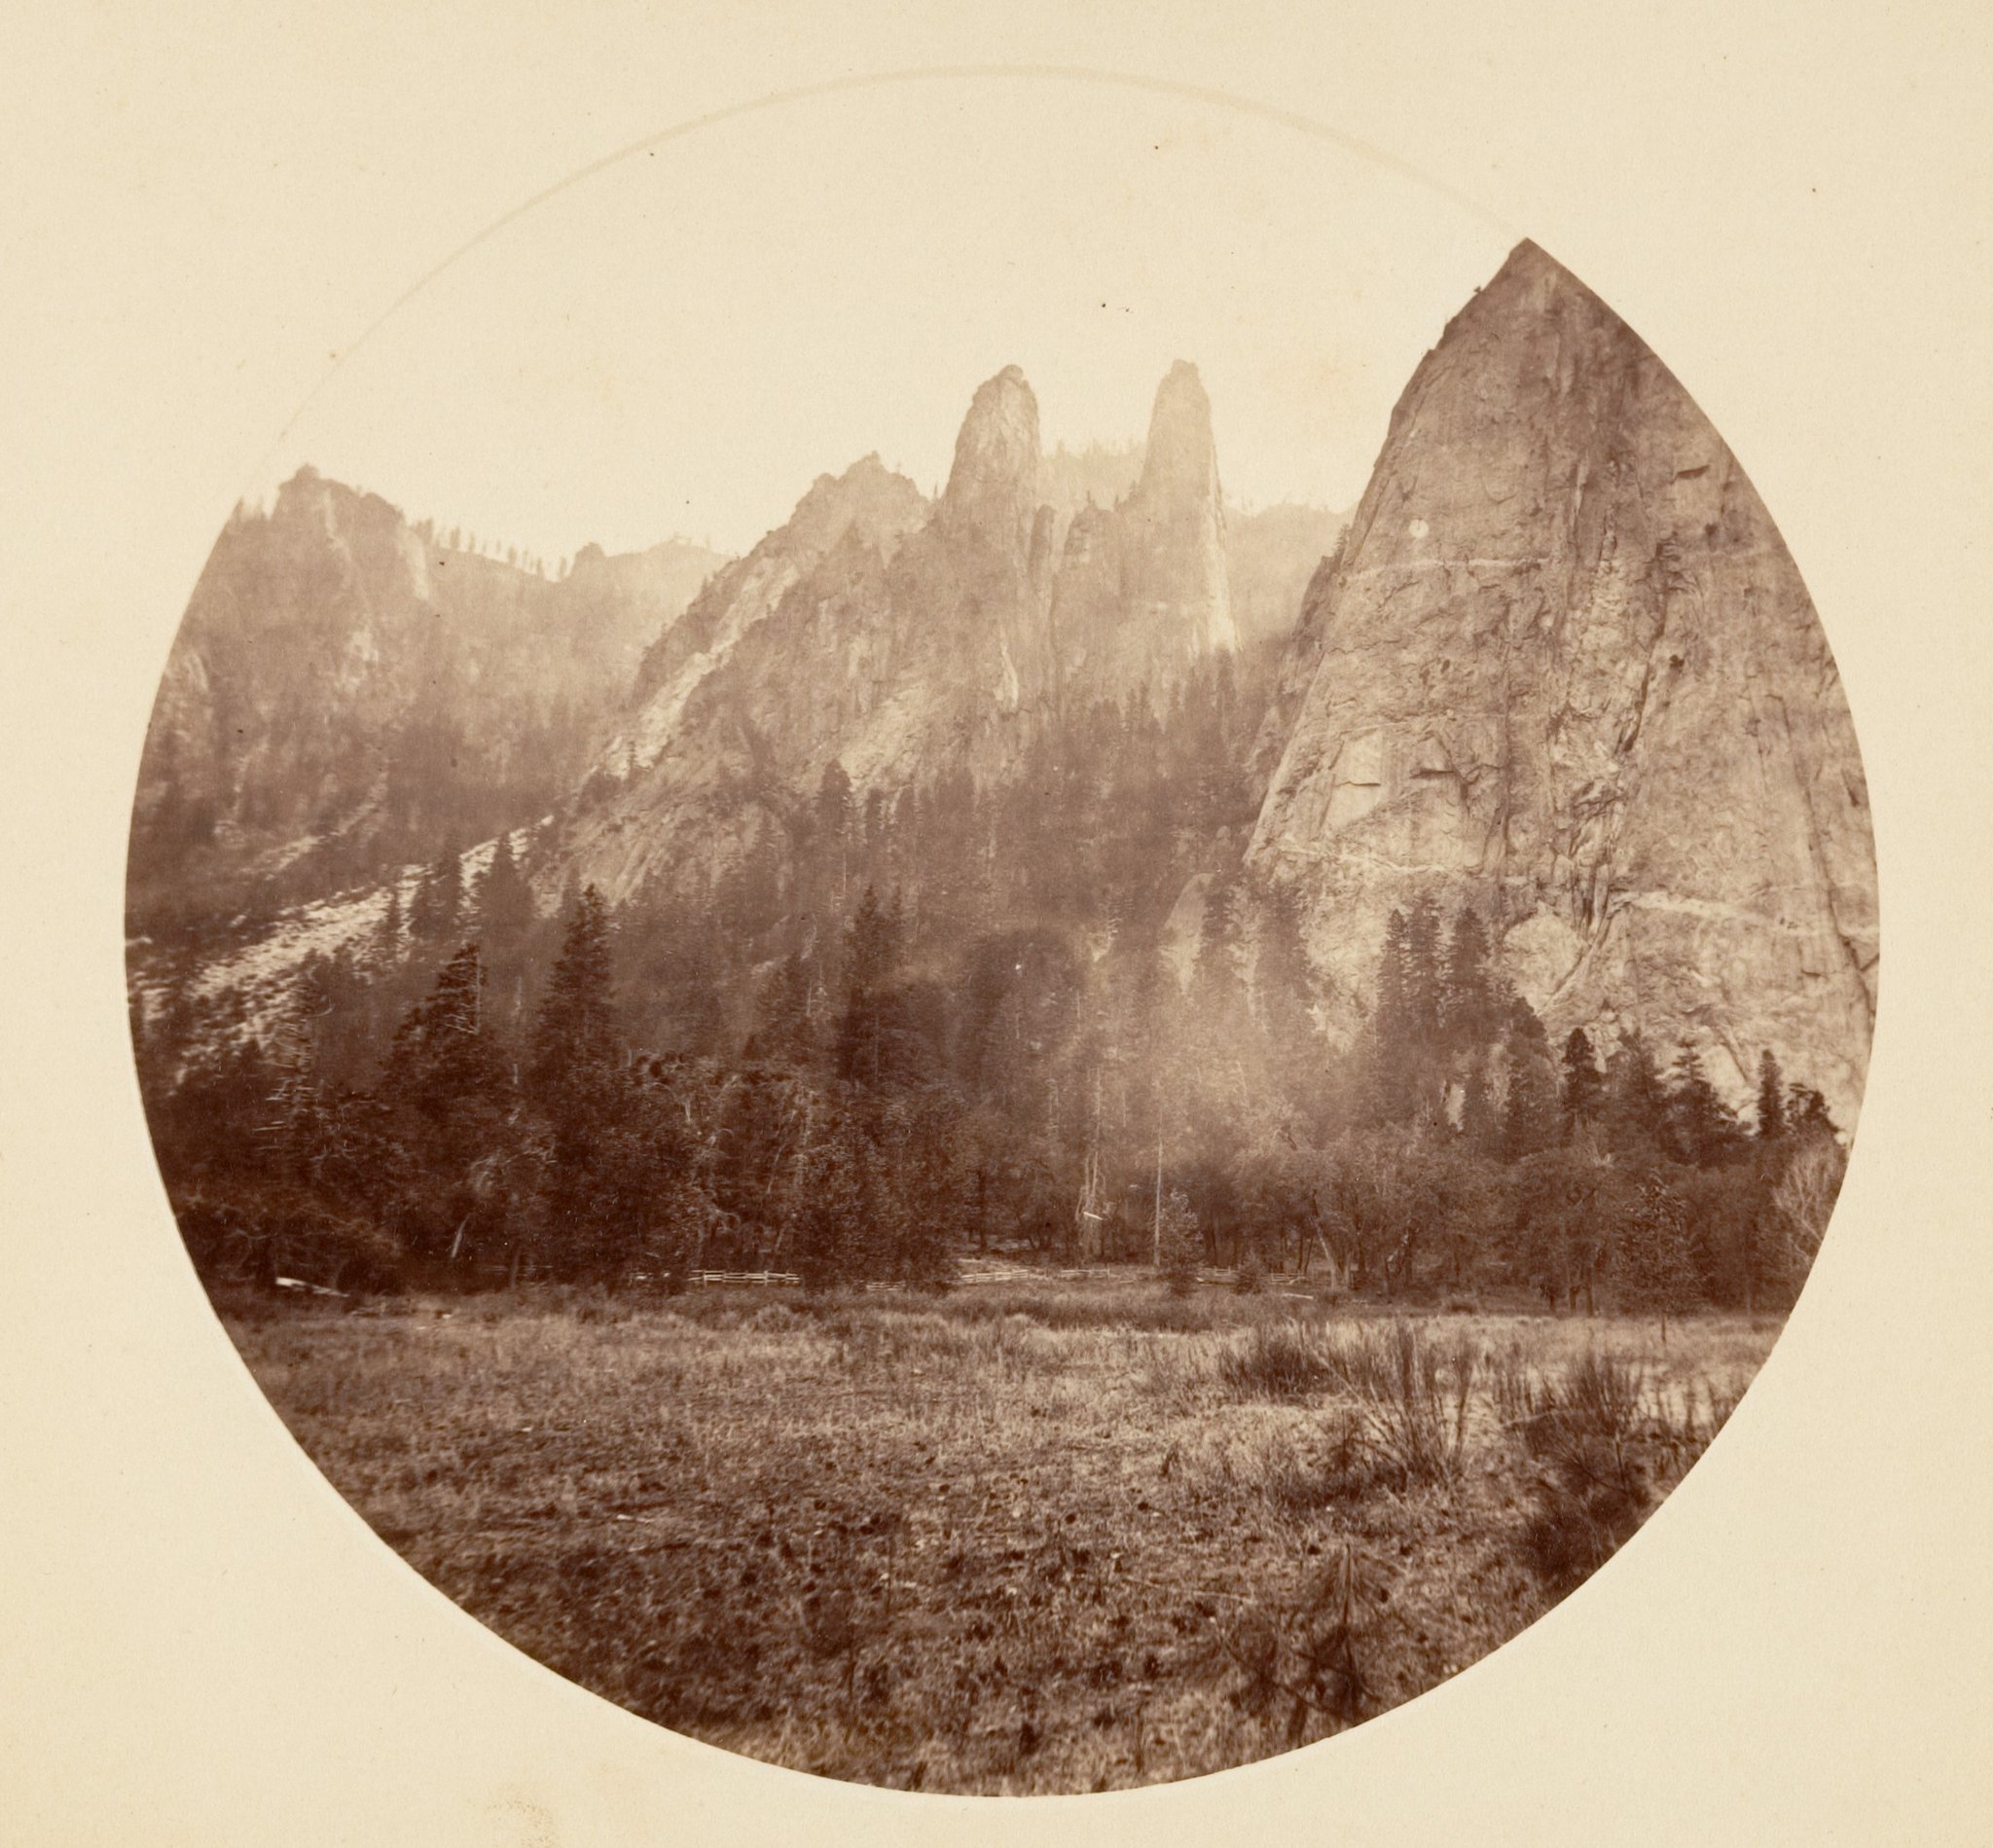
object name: photograph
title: [Yosemite National Park, California]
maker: carleton e. watkins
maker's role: artist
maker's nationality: american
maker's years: 1829-1916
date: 1878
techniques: albumen silver print, glass negative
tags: mountains,landscapes